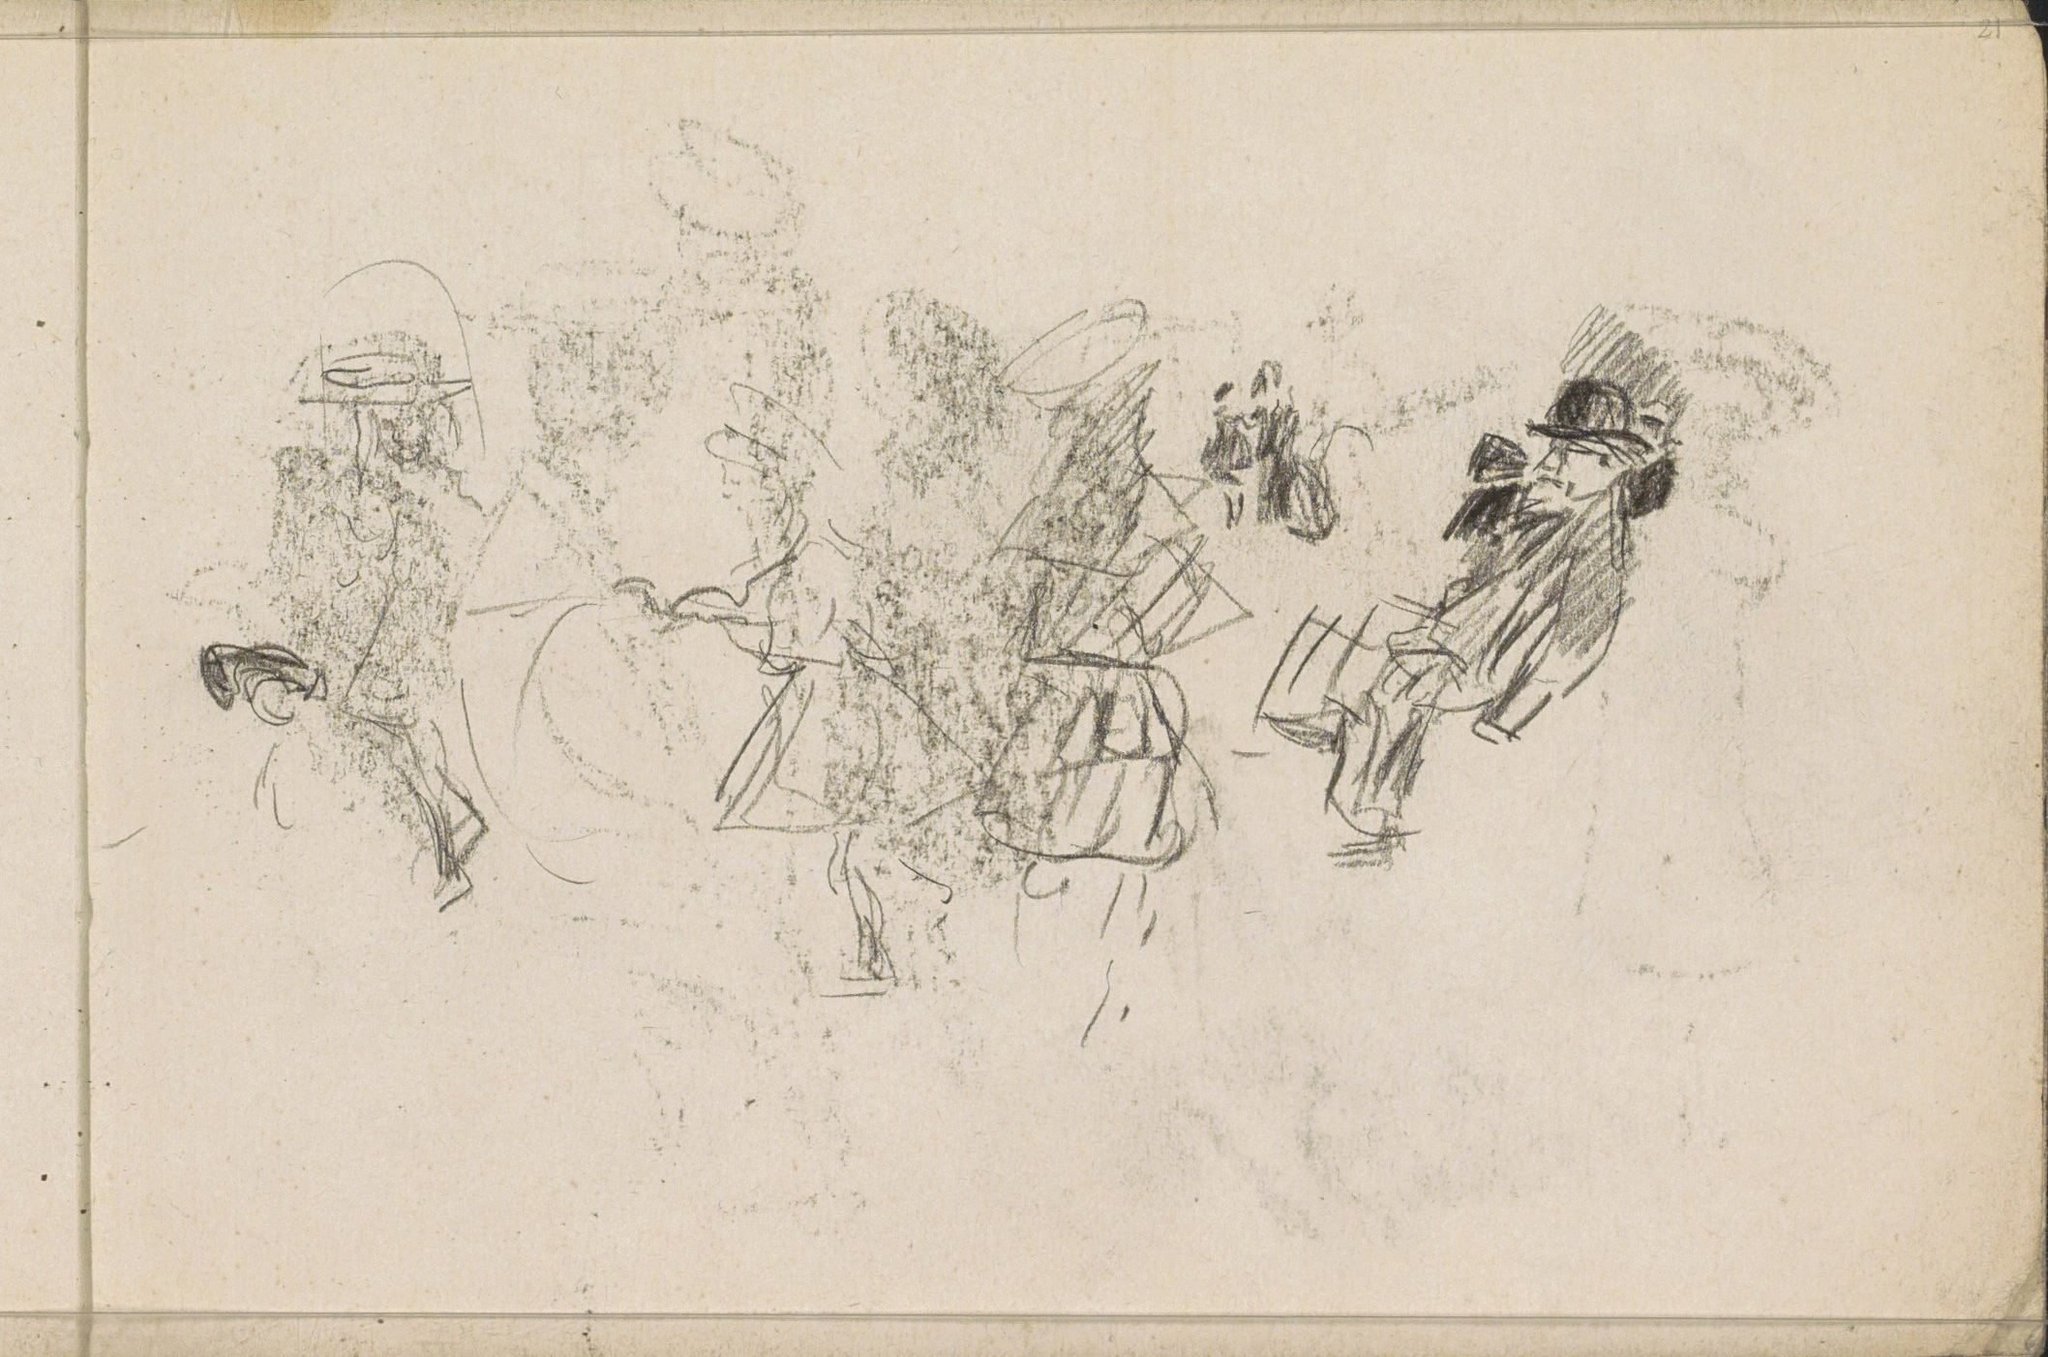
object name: sketchbook leaf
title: Spelende kinderen en een man op een bank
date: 1875-1934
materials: chalk, paper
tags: adult man (+ sitting), bench, girl (child between toddler and youth), (bowling a) hoop, jumping-rope games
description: Een meisje hoepelt en een ander meisje springt waarschijnlijk touwtje. Pagina 21 uit schetsboek XLVI met 32 pagina's.